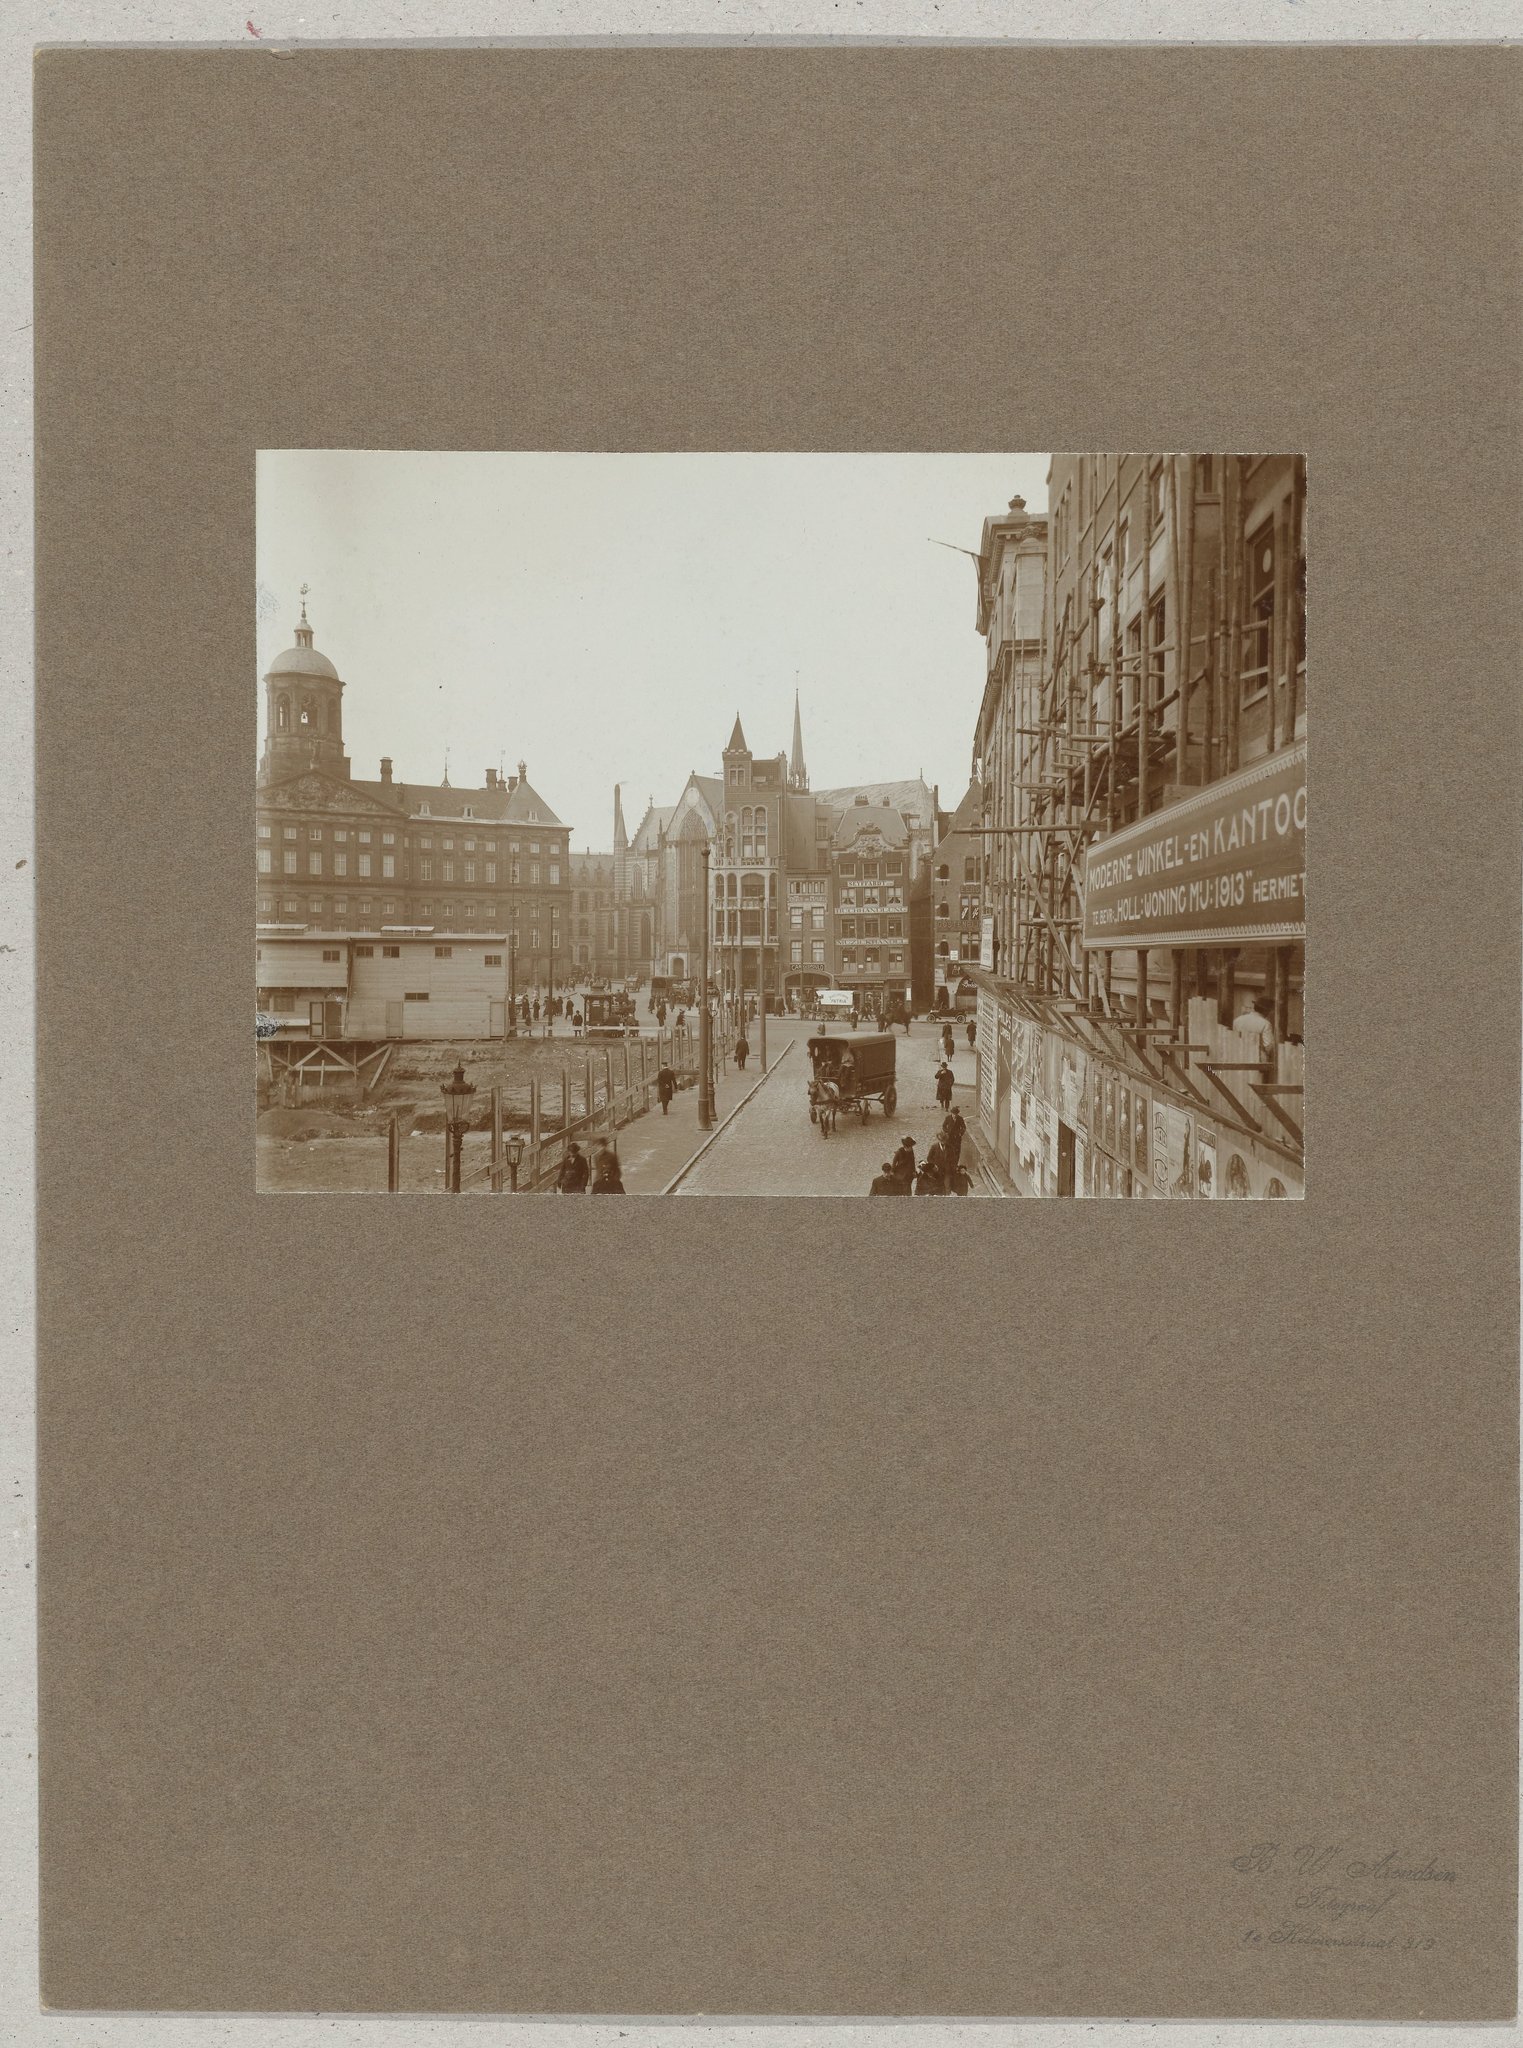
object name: photograph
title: Gezicht op de Dam te Amsterdam tijdens werkzaamheden voor de verruiming van de Dam, 1916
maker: barend w. arendsen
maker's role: fotograaf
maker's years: 1867-1918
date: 1916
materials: cardboard, paper, photographic support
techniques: collodion silver print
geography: amsterdam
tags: building activities, square, place, circus, etc., amsterdam